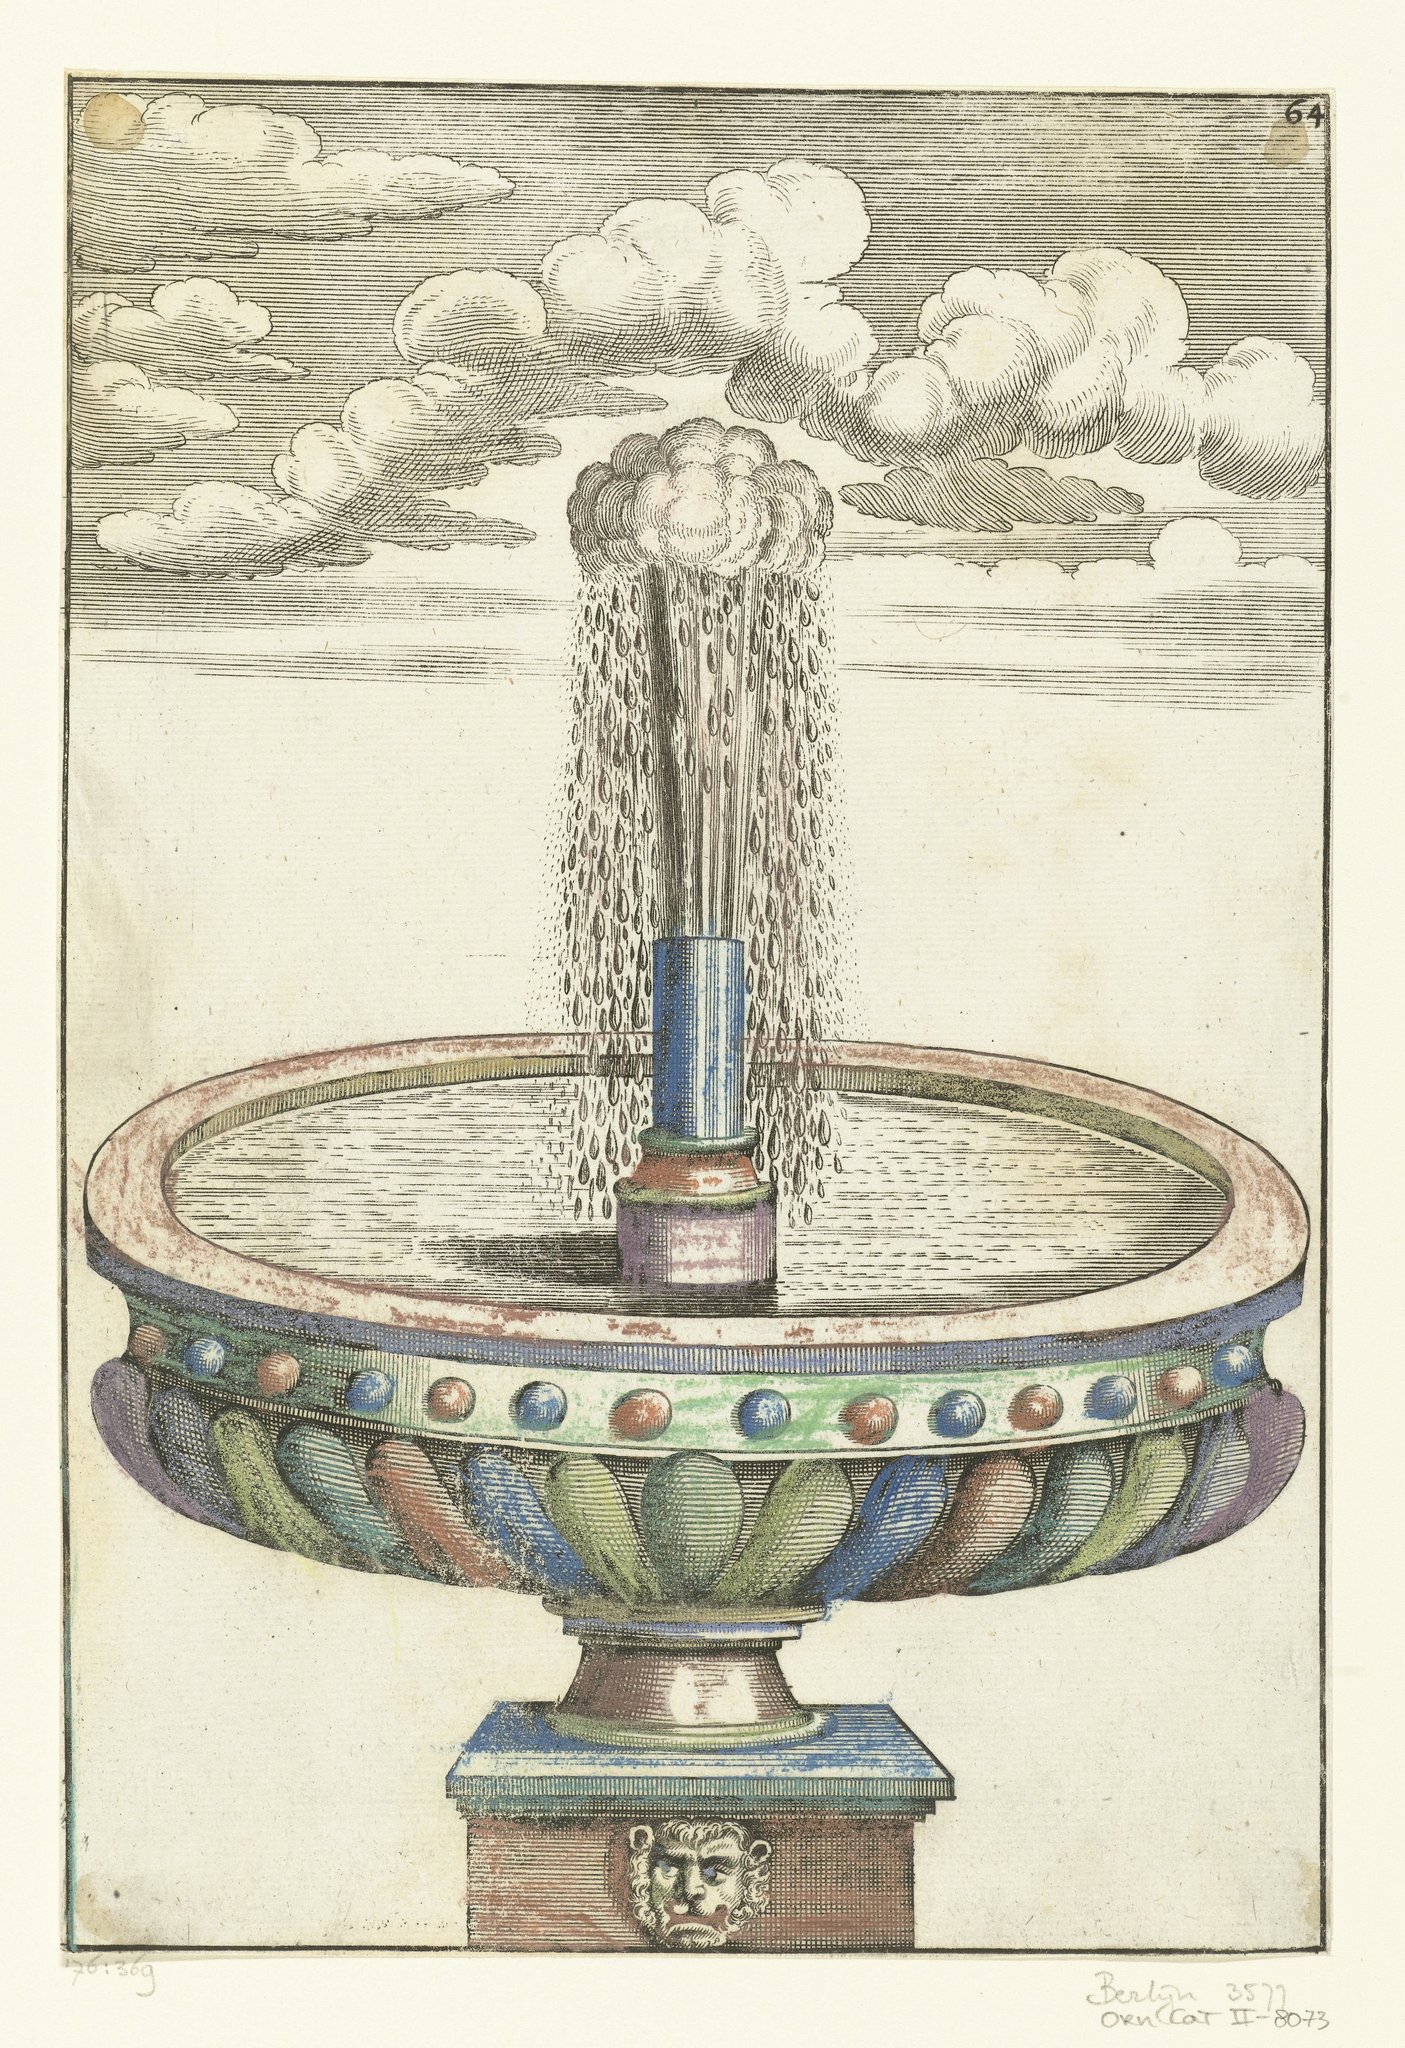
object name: print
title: Rond bassin op voetstuk met leeuwenkop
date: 1664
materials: paper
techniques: etching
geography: nuremberg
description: Het water spuit uit een pijp in het midden. Blad 64 uit deel III van een serie bestaande uit 226 bladen, verdeeld over vier boeken, elk met een eigen titelblad.